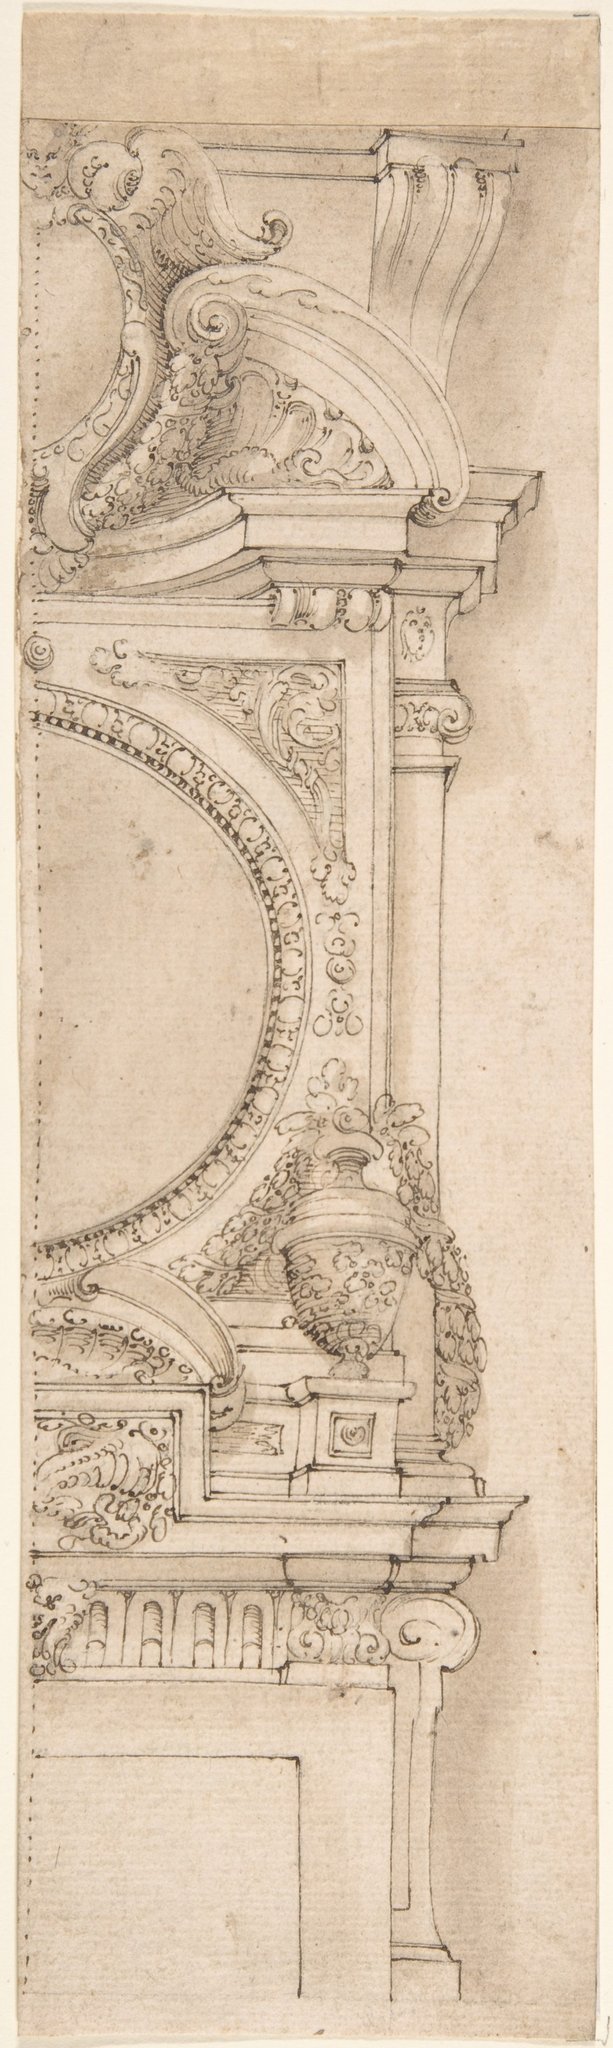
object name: drawing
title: Design for the right half of a chimneypiece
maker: anonymous, italian, 17th century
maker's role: artist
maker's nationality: italian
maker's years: 1600-1700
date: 1601-1700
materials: ink, drawing material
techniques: brush, pen, wash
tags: fireplaces